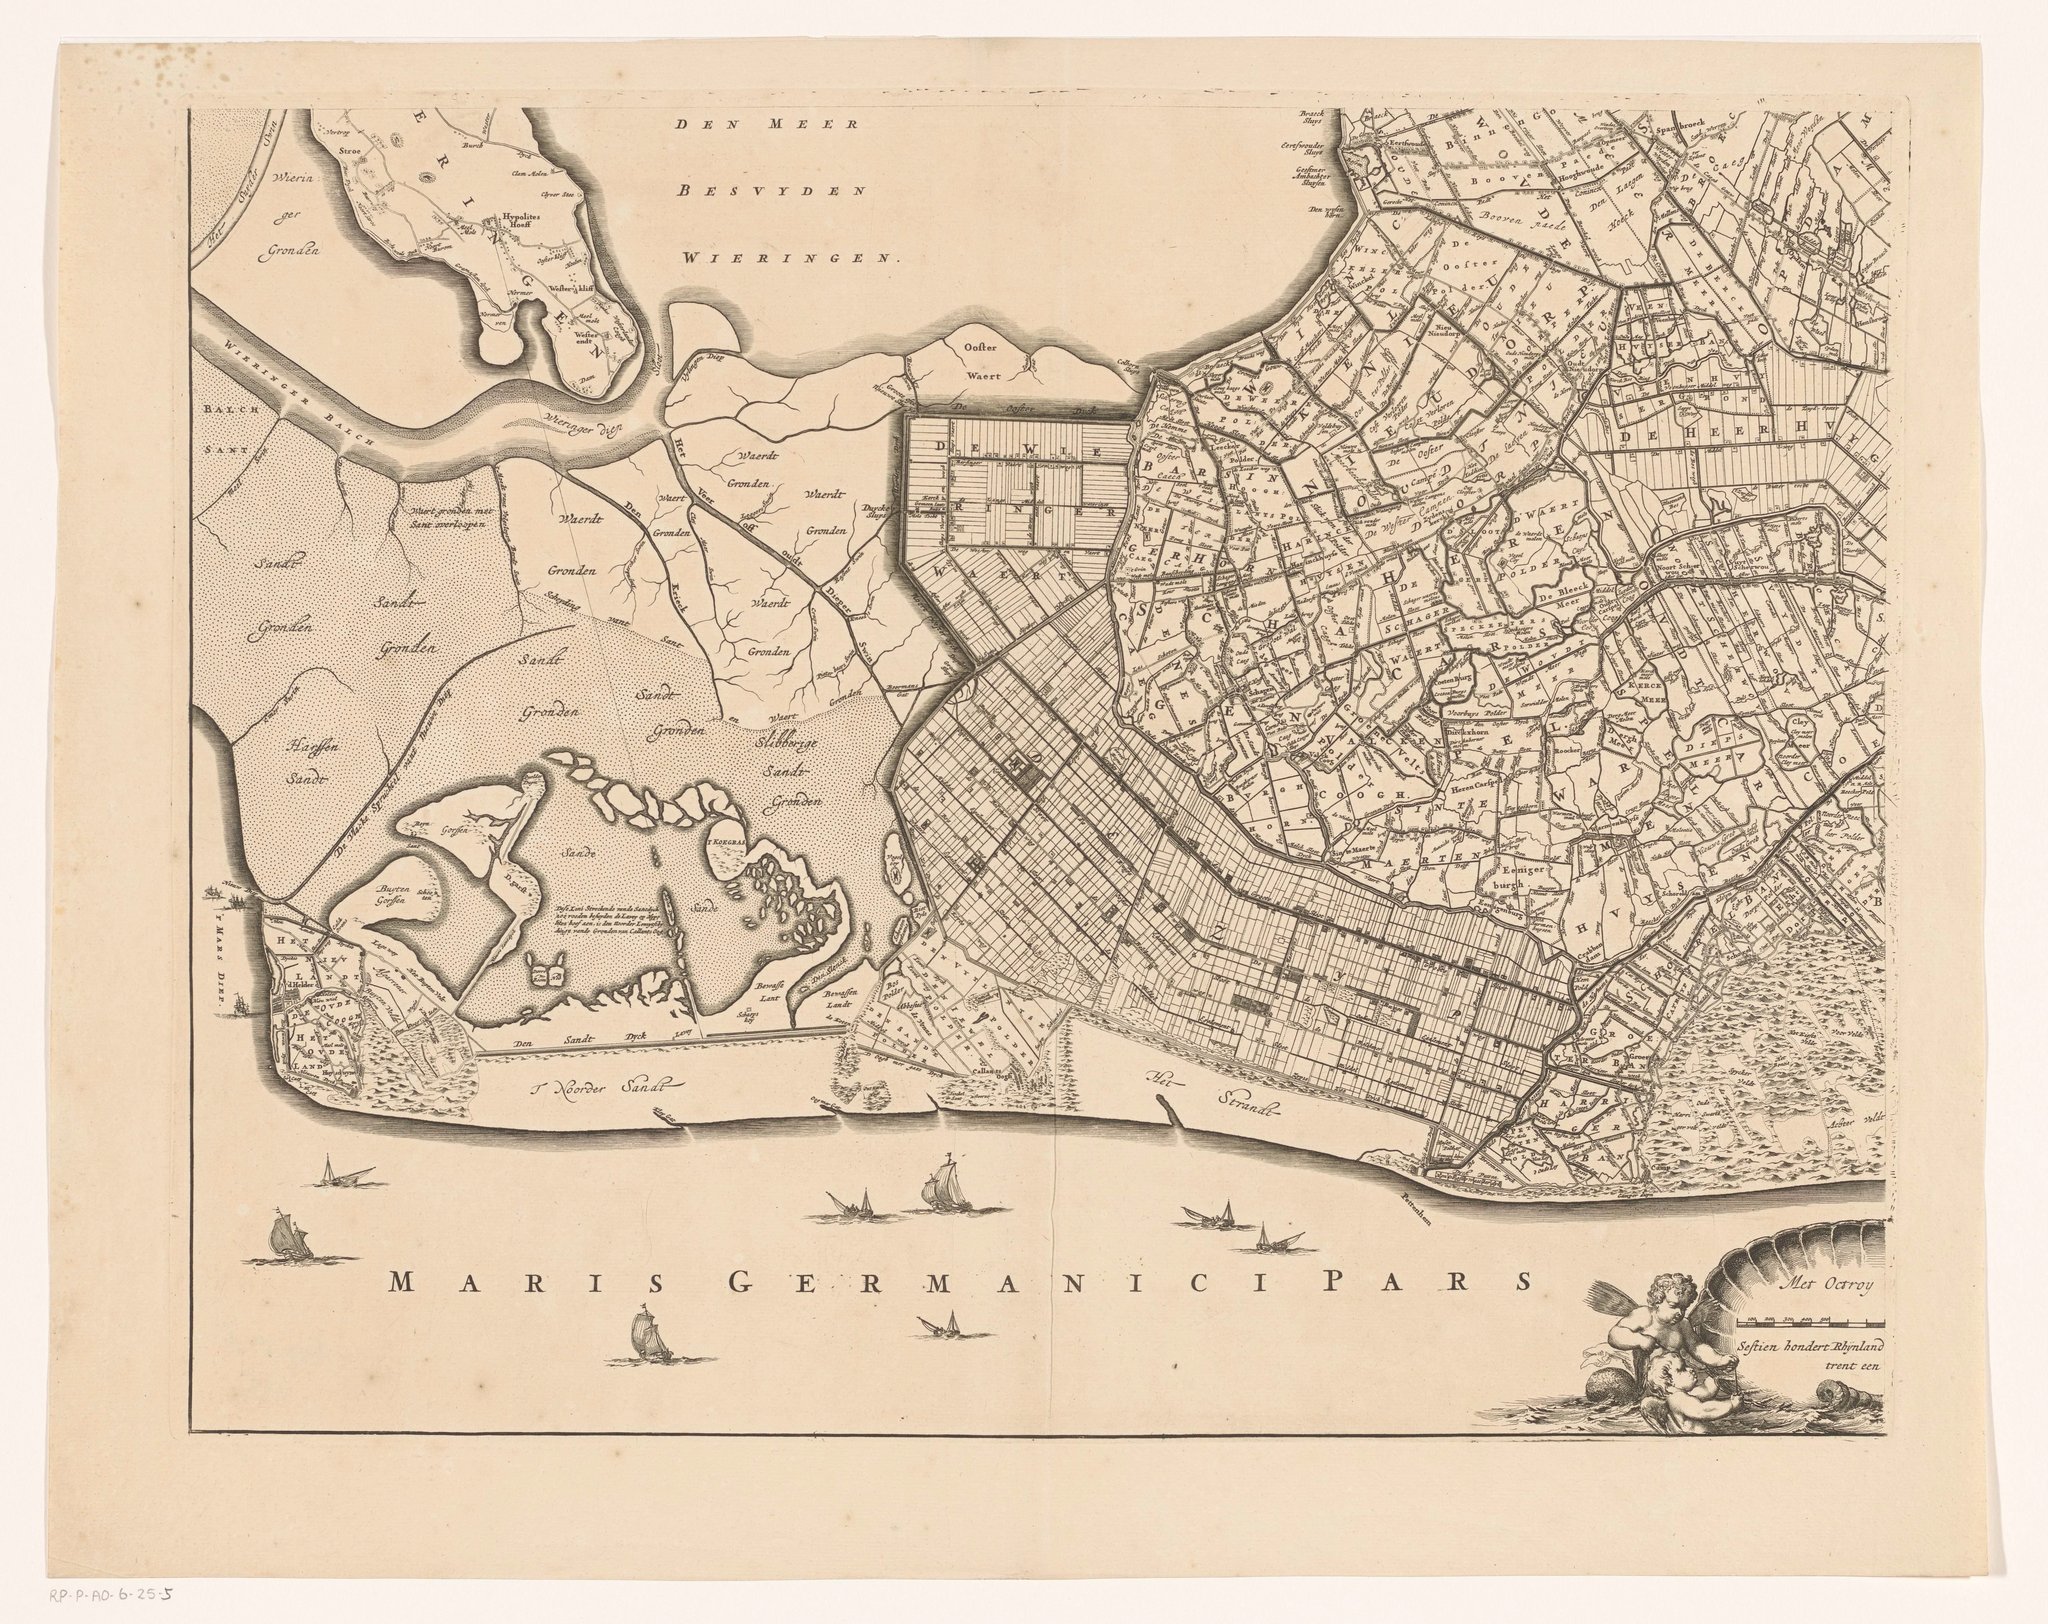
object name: print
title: 't Hoogh-heemraetschap vande Uytwaterende Sluysen in Kennemerlant ende West-Frieslant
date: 1733-1745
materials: paper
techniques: engraving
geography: amsterdam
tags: maps of separate countries or regions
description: In de collectie van het Rijksprentenkabinet bevinden zich verschillende exemplaren en staten van de vierdelige kaart waar dit blad (deel linksonder op de kaart) onderdeel van is. De kaarten zijn te dateren aan de hand van de namen van de dijkgraaf, hoogheemraden en rentmeester, te vinden op de twee bovenste bladen van de kaart. Omdat de twee onderste bladen door de jaren heen onveranderd zijn gebleven en niet duidelijk is welke losse onderste bladen bij welke bovenste horen, kunnen de onderste bladen niet precies gedateerd worden. Wel kan gesteld worden dat alle losse exemplaren van het blad dat het deel linksonder op de kaart vormt in de collectie óf bij de vierde staat uit 1734-1739, óf bij de vijfde staat uit 1745 horen.